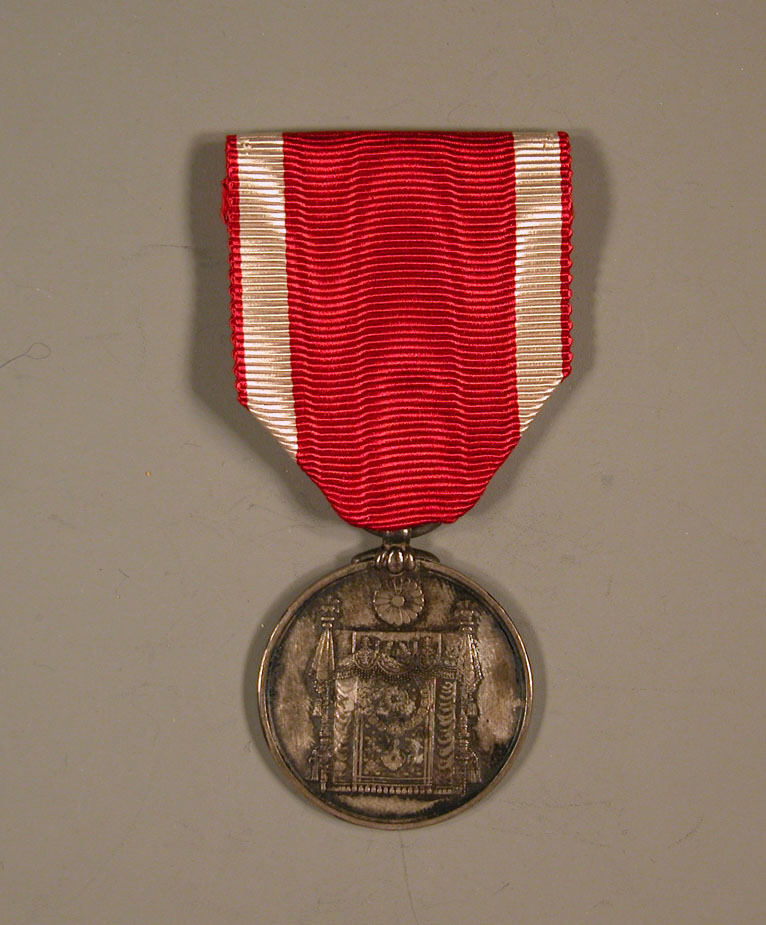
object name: medal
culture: japanese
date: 1867-1900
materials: ribbon, silver